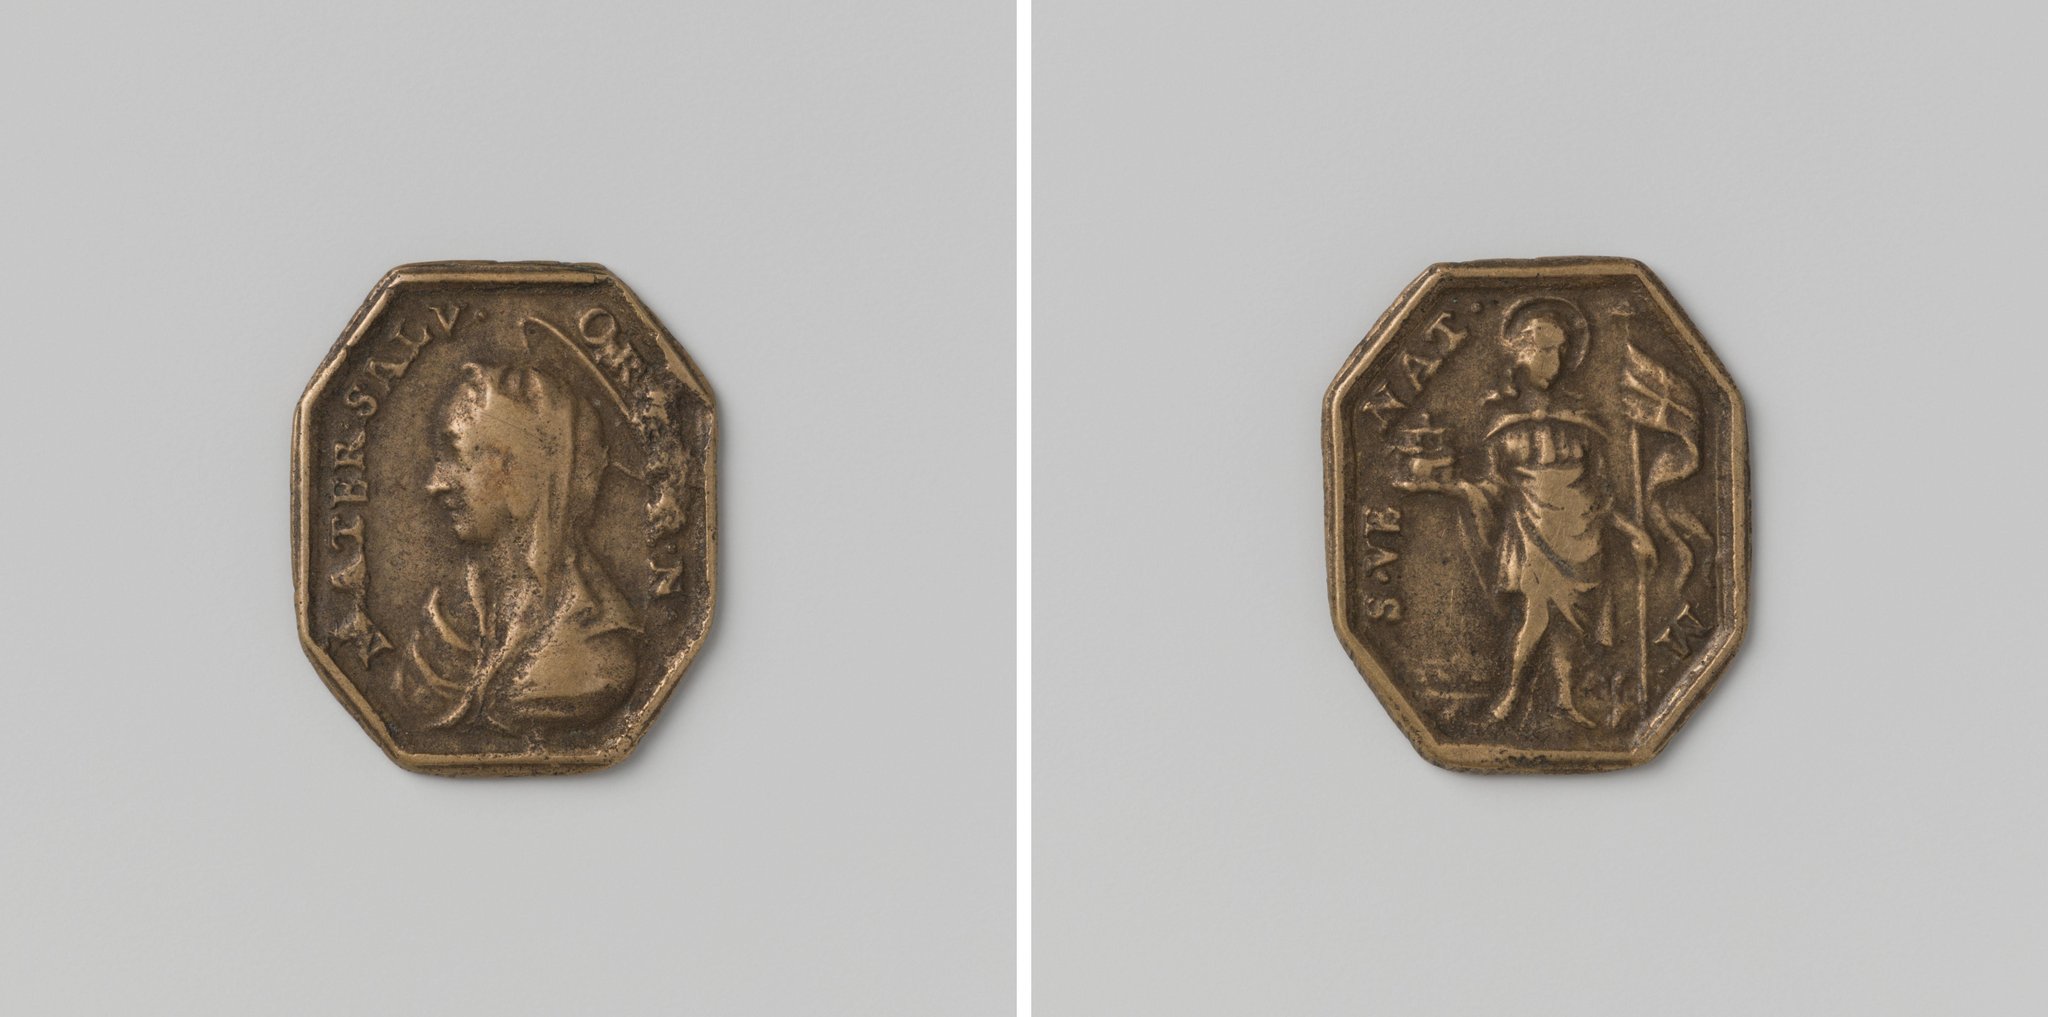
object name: devotional token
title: Maagd Maria en Christus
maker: Anonymous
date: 1600-1800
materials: brass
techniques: striking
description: Messing achthoekige penning. Voorzijde: naar links gewende gesluierde Maria met aureool binnen omschrift. Keerzijde: Christus met aureool en face houdt banier in linker- en wereldbol in rechterhand binnen omschrift.